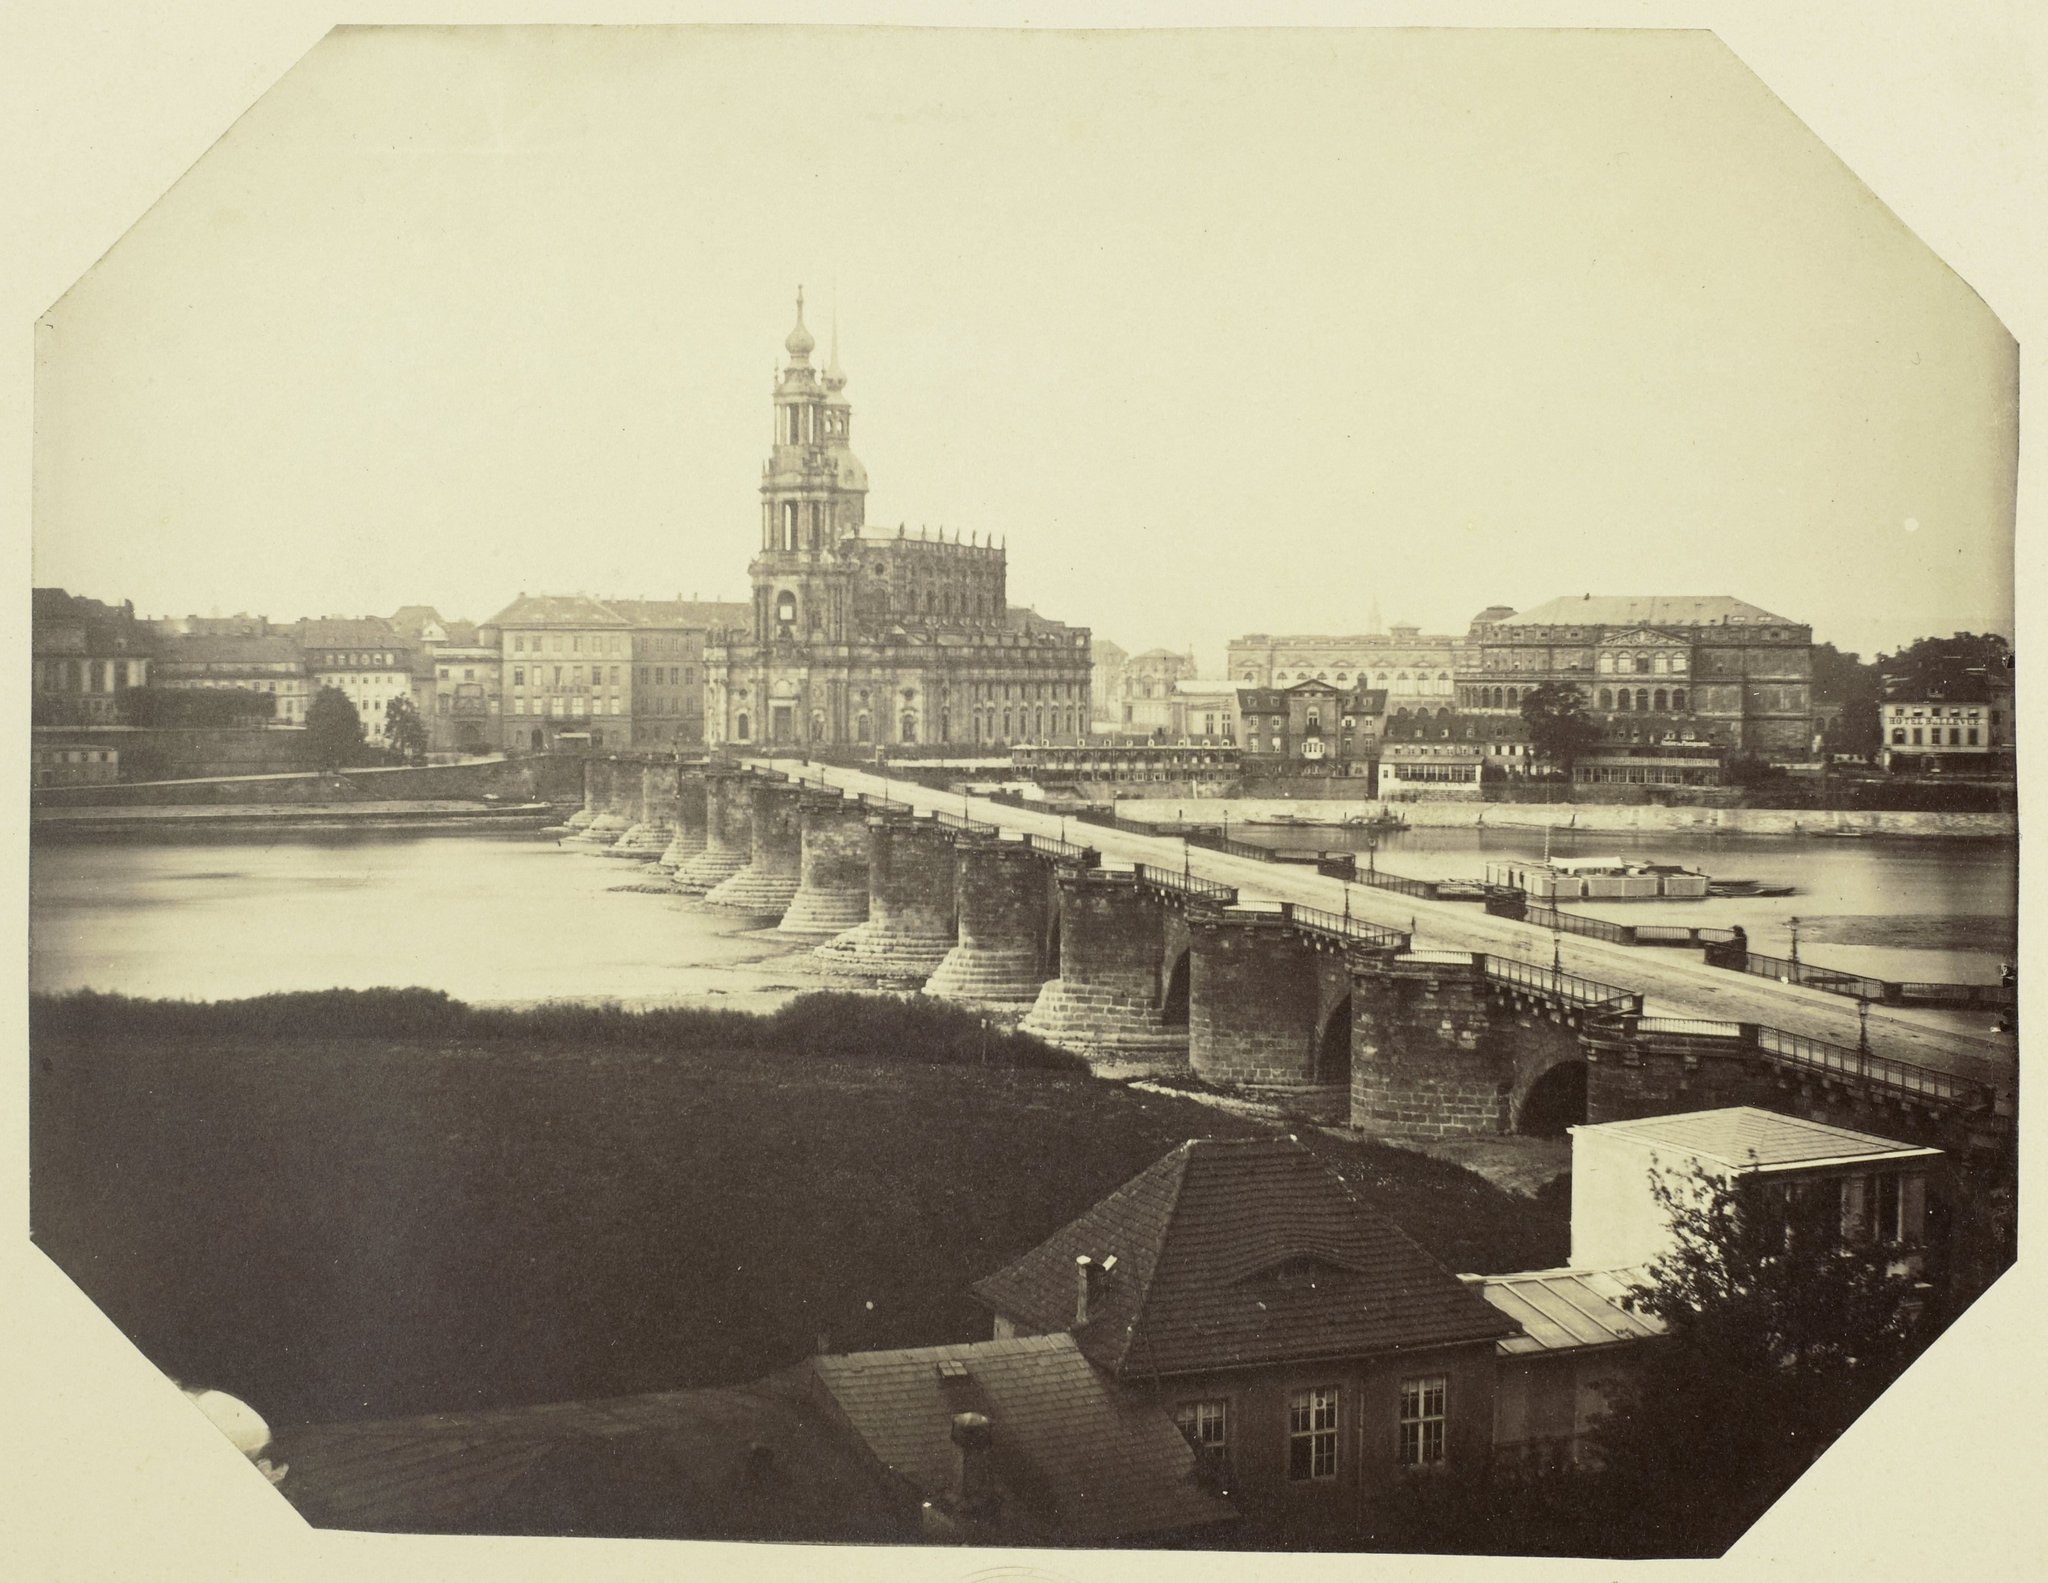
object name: photograph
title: Gezicht op de Altstadt van Dresden met de brug over de Elbe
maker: hermann krone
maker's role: fotograaf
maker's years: 1827-1916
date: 1857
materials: cardboard, photographic support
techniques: salted paper print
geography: dresden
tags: prospect of city, town panorama, silhouette of city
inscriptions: date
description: Gezicht op de Altstadt van Dresden met de brug over de Elbe. Nummer 10 uit serie foto's van Dresden.